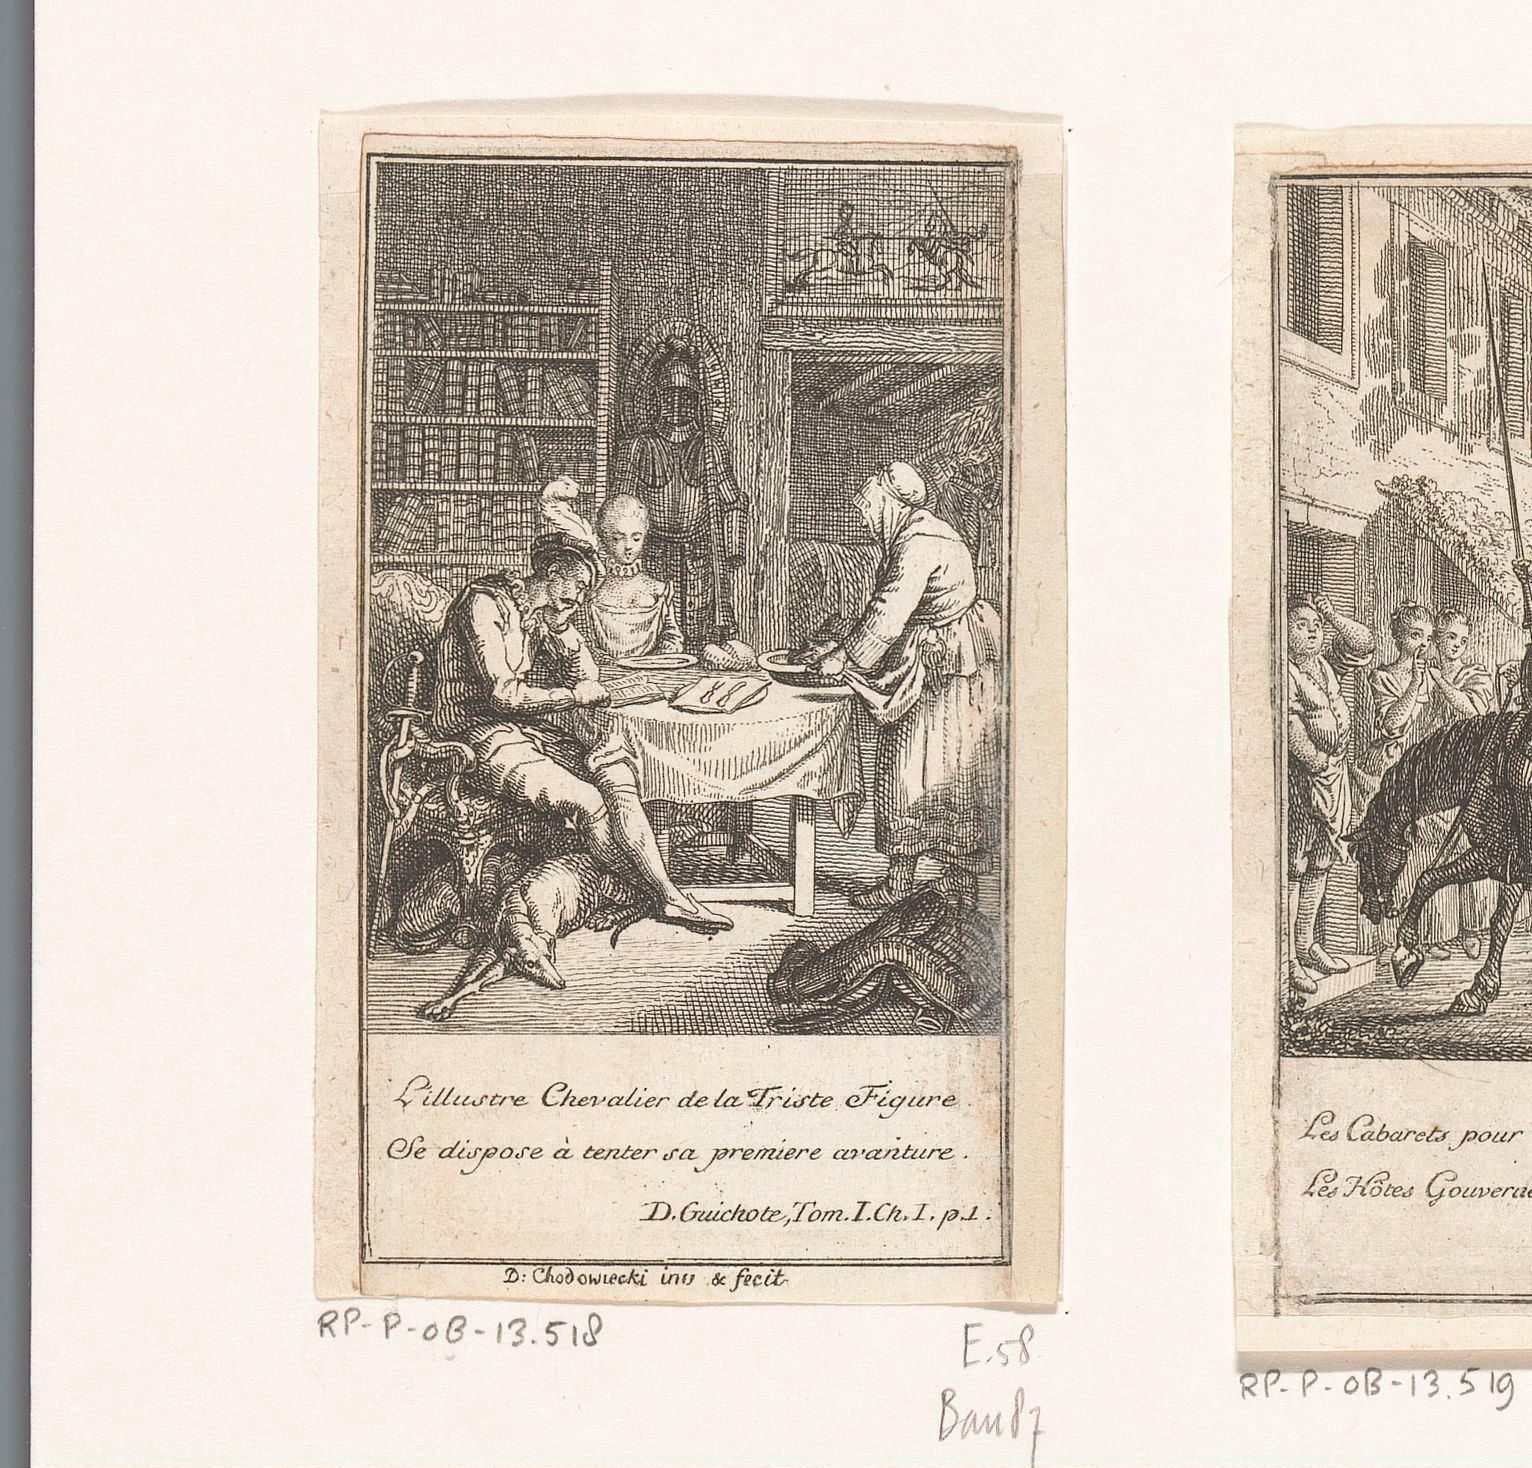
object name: print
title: Don Quichot lezend in een ridderroman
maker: daniel nikolaus chodowiecki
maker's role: draughtsman, print maker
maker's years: 1726-1801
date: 1770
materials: paper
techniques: etching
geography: berlin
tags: bookshelves, reading, armour, book - mm - book open, don quixote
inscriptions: collector's mark: Lugt 2228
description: Eerste prent van een serie van twaalf scènes die het verhaal van Don Quichot door Miguel de Cervantes Saavedra illustreren. De scènes werden op een plaat geëtst. Deze serie werd ook gebruikt in: 'Almanac Genealogique pour l'an 1771'.